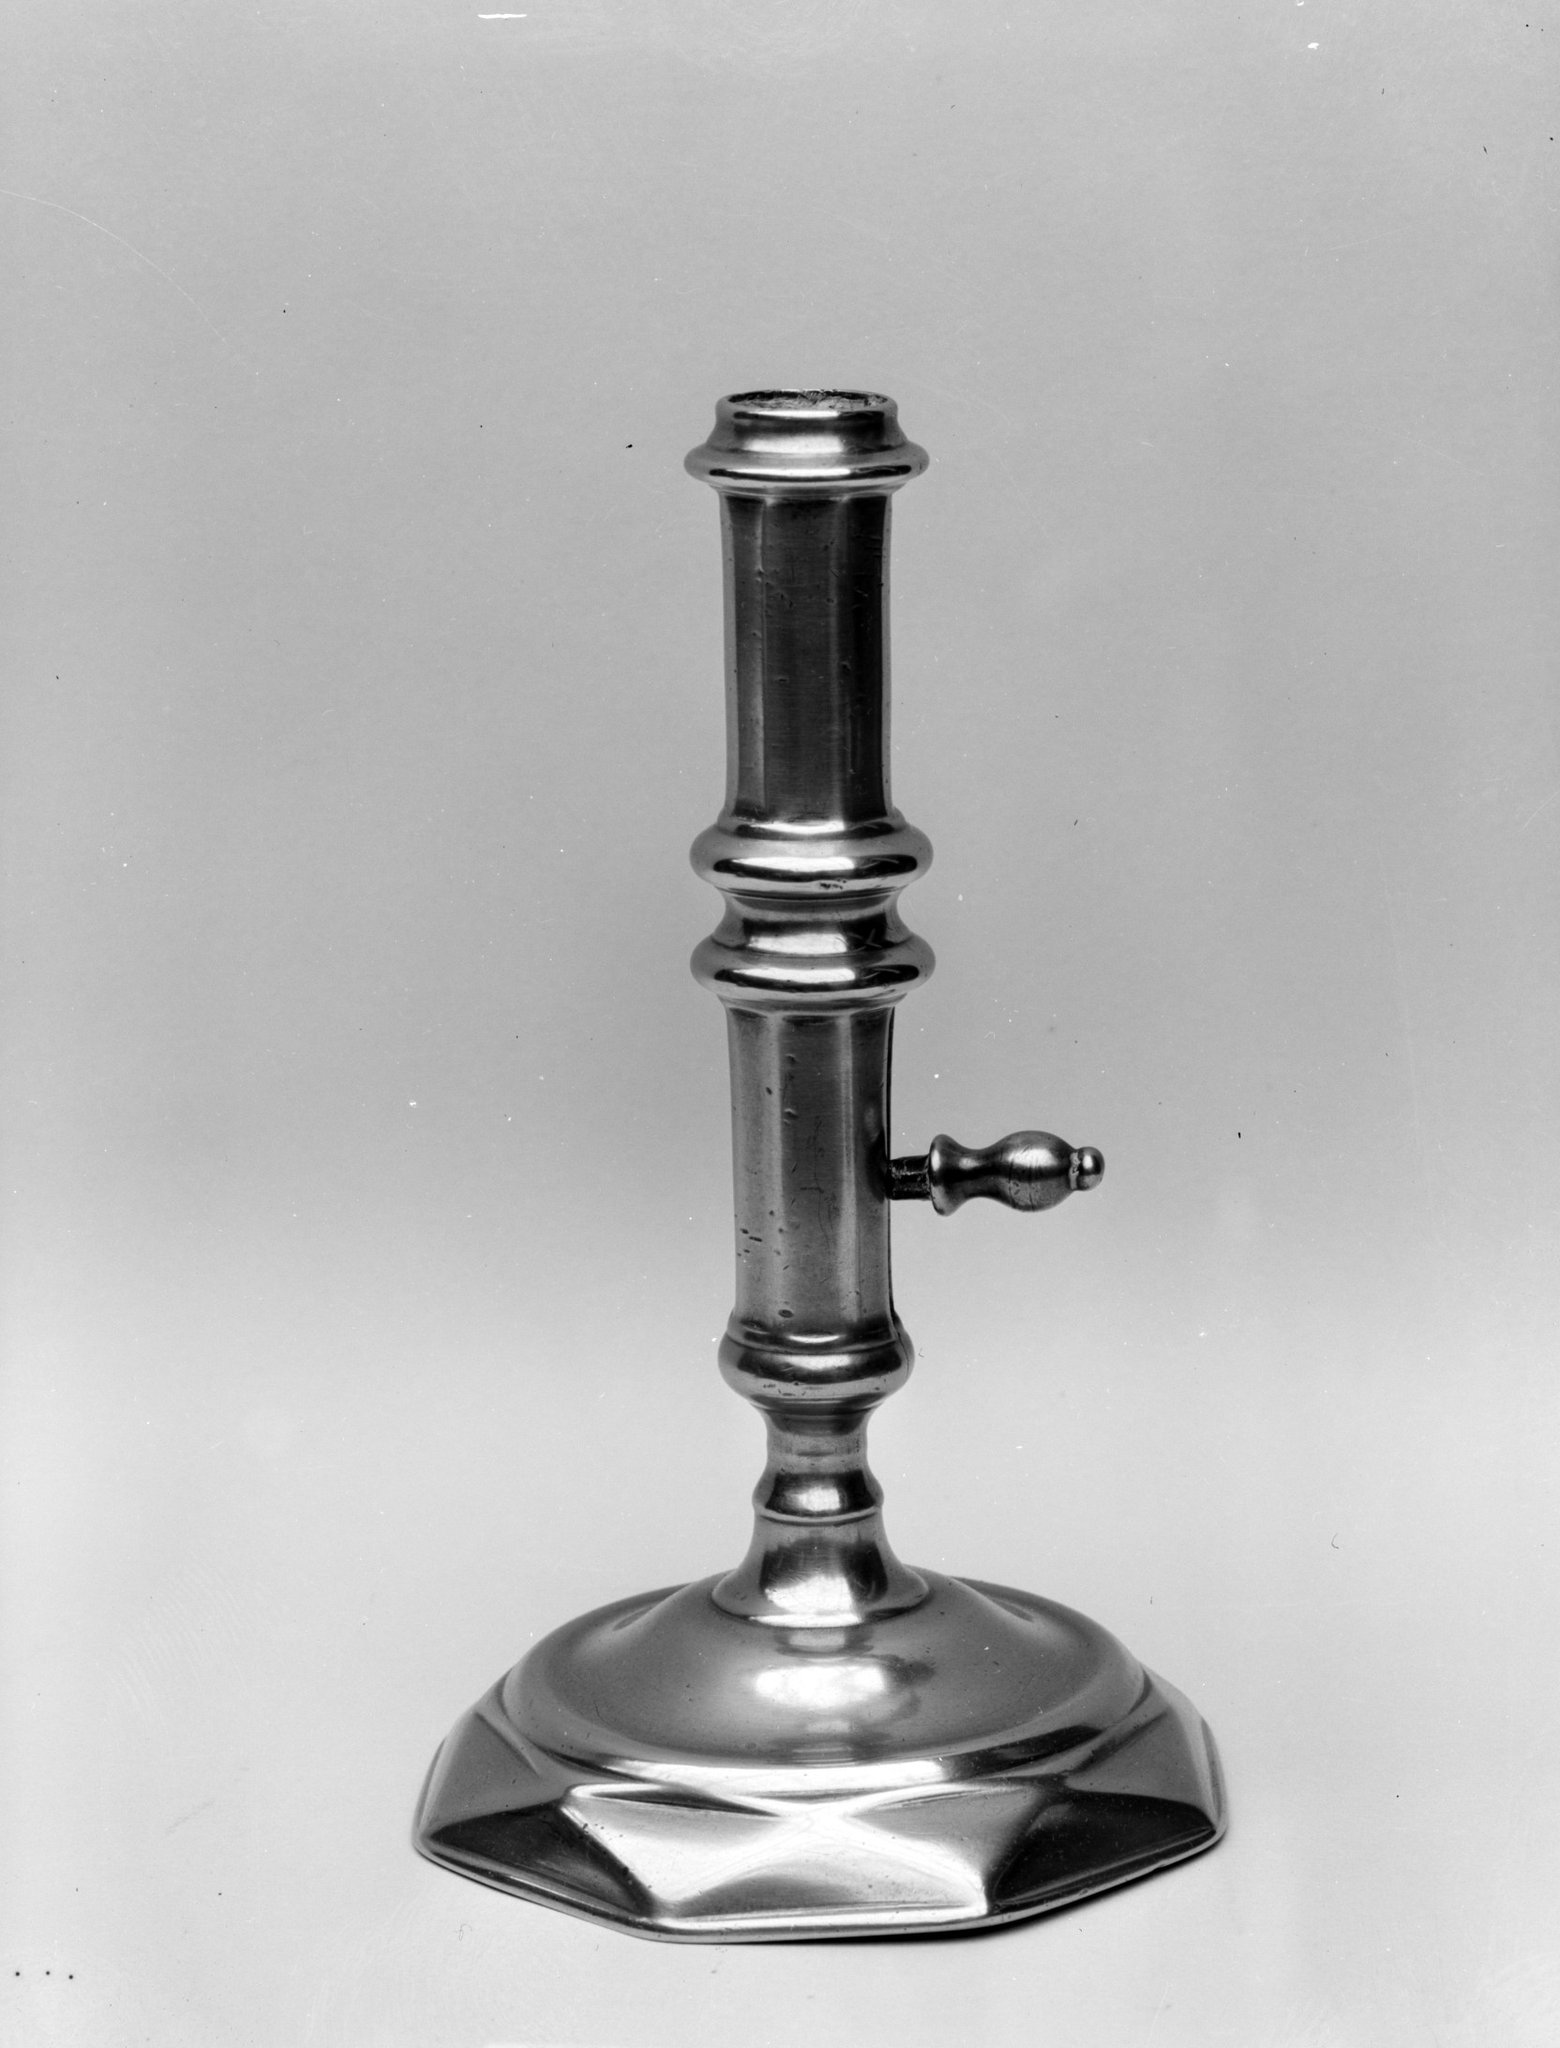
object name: candlestick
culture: american or british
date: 1700-1800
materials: brass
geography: england